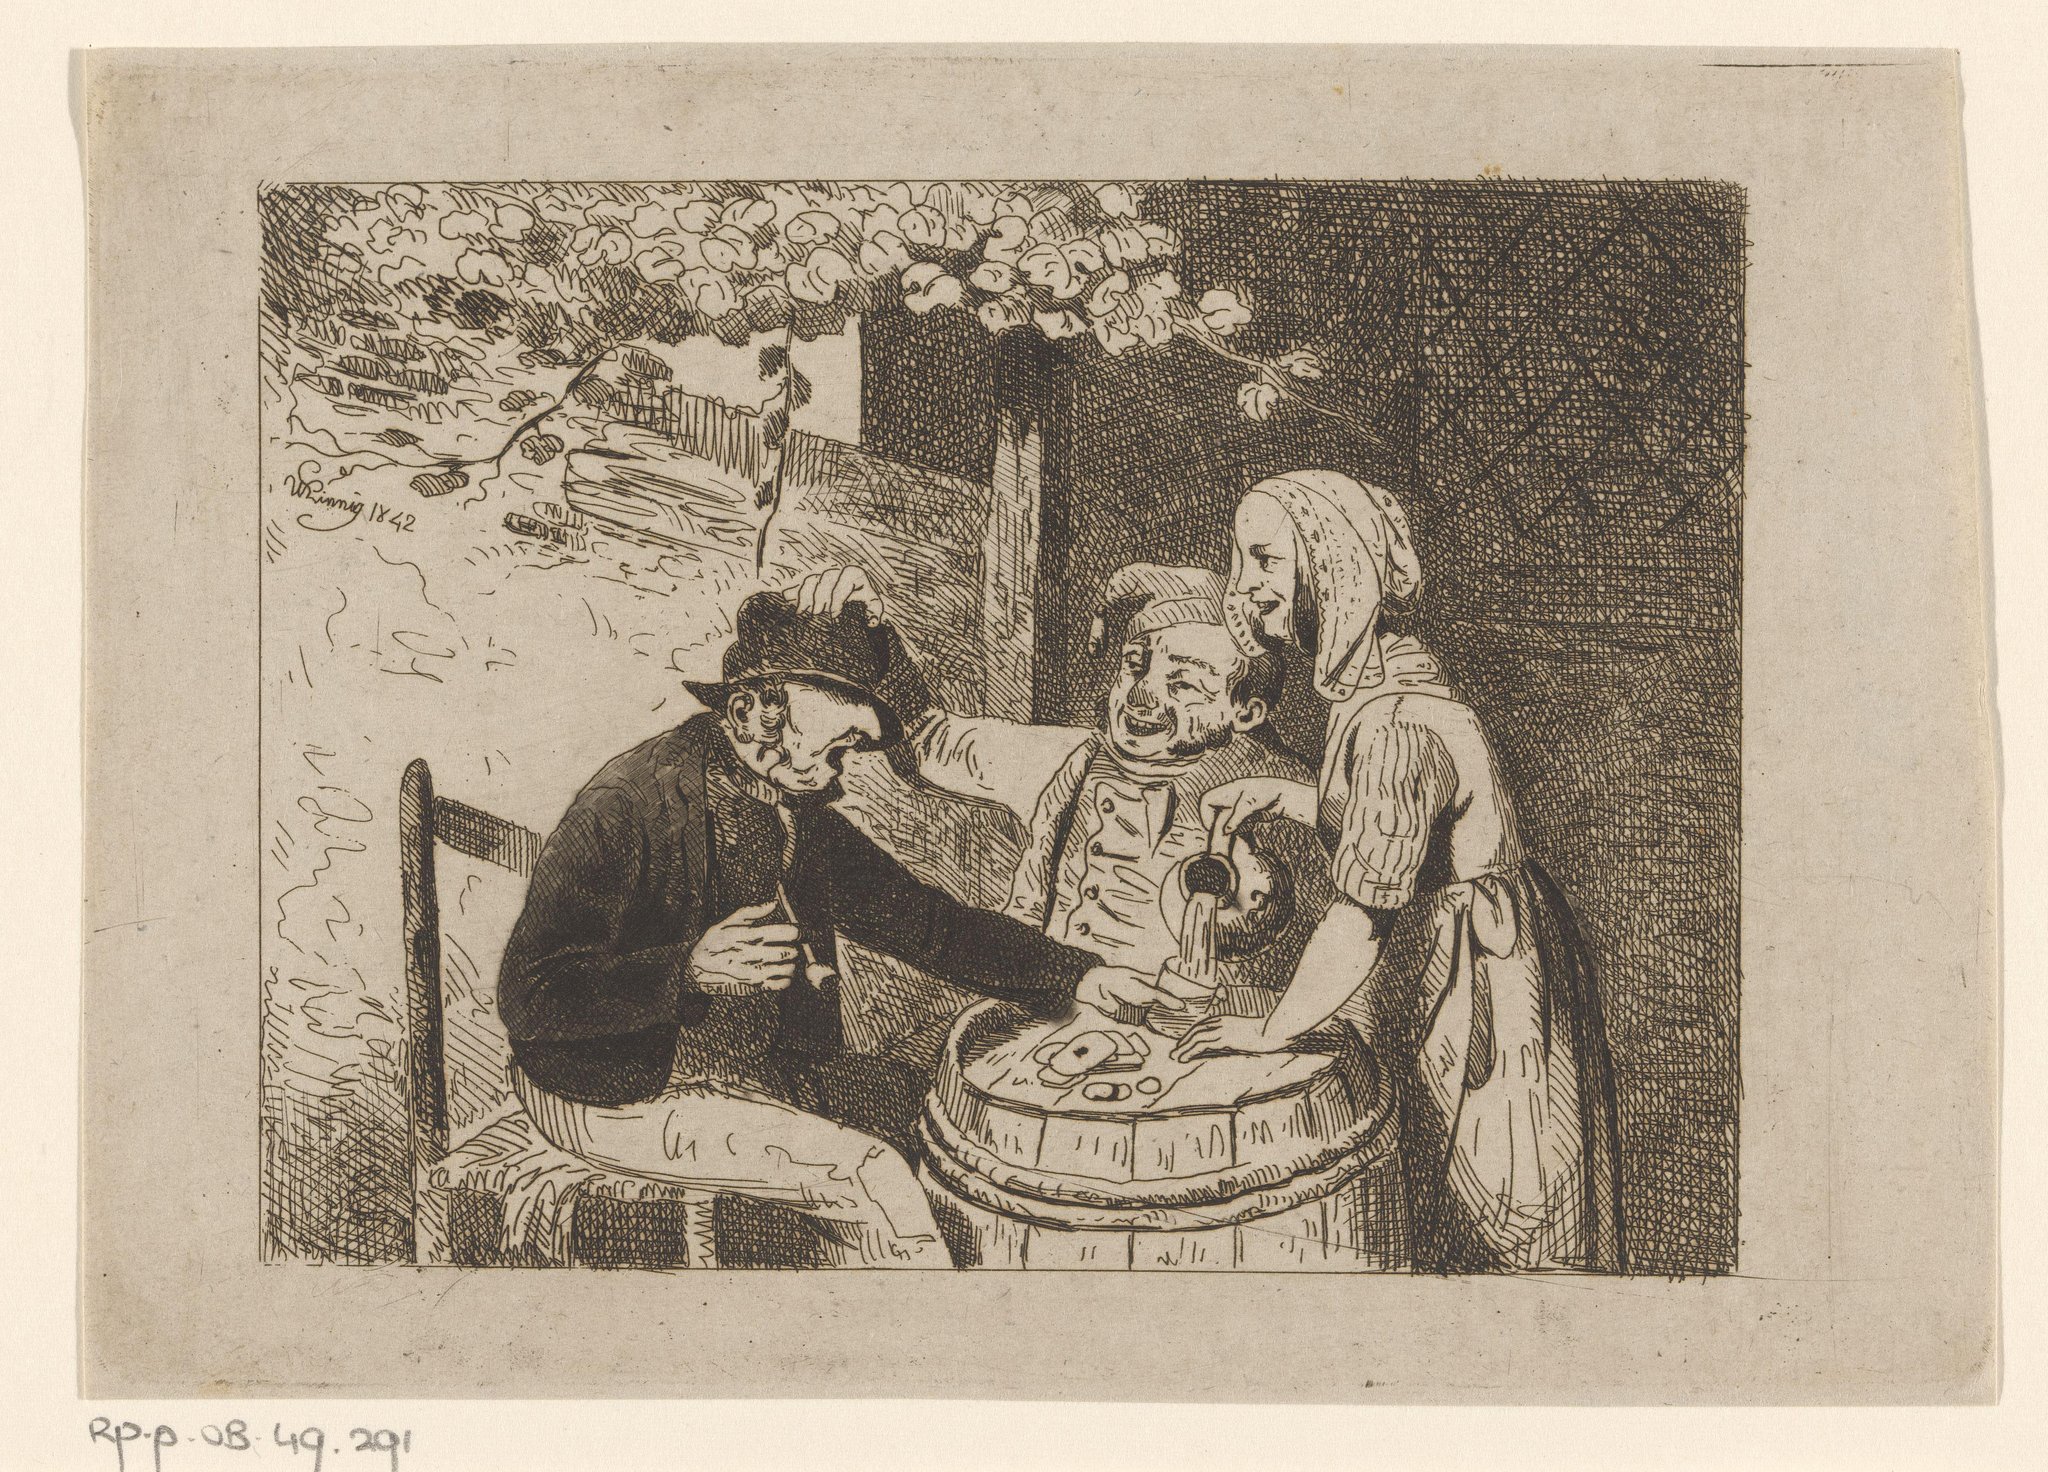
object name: print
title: Vrouw schenkt een glas in voor twee kaartende mannen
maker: willem linnig (i)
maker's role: print maker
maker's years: 1819-1885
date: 1842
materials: paper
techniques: drypoint, etching, intaglio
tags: playing-cards, beer, ale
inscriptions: collector's mark: Lugt 2228